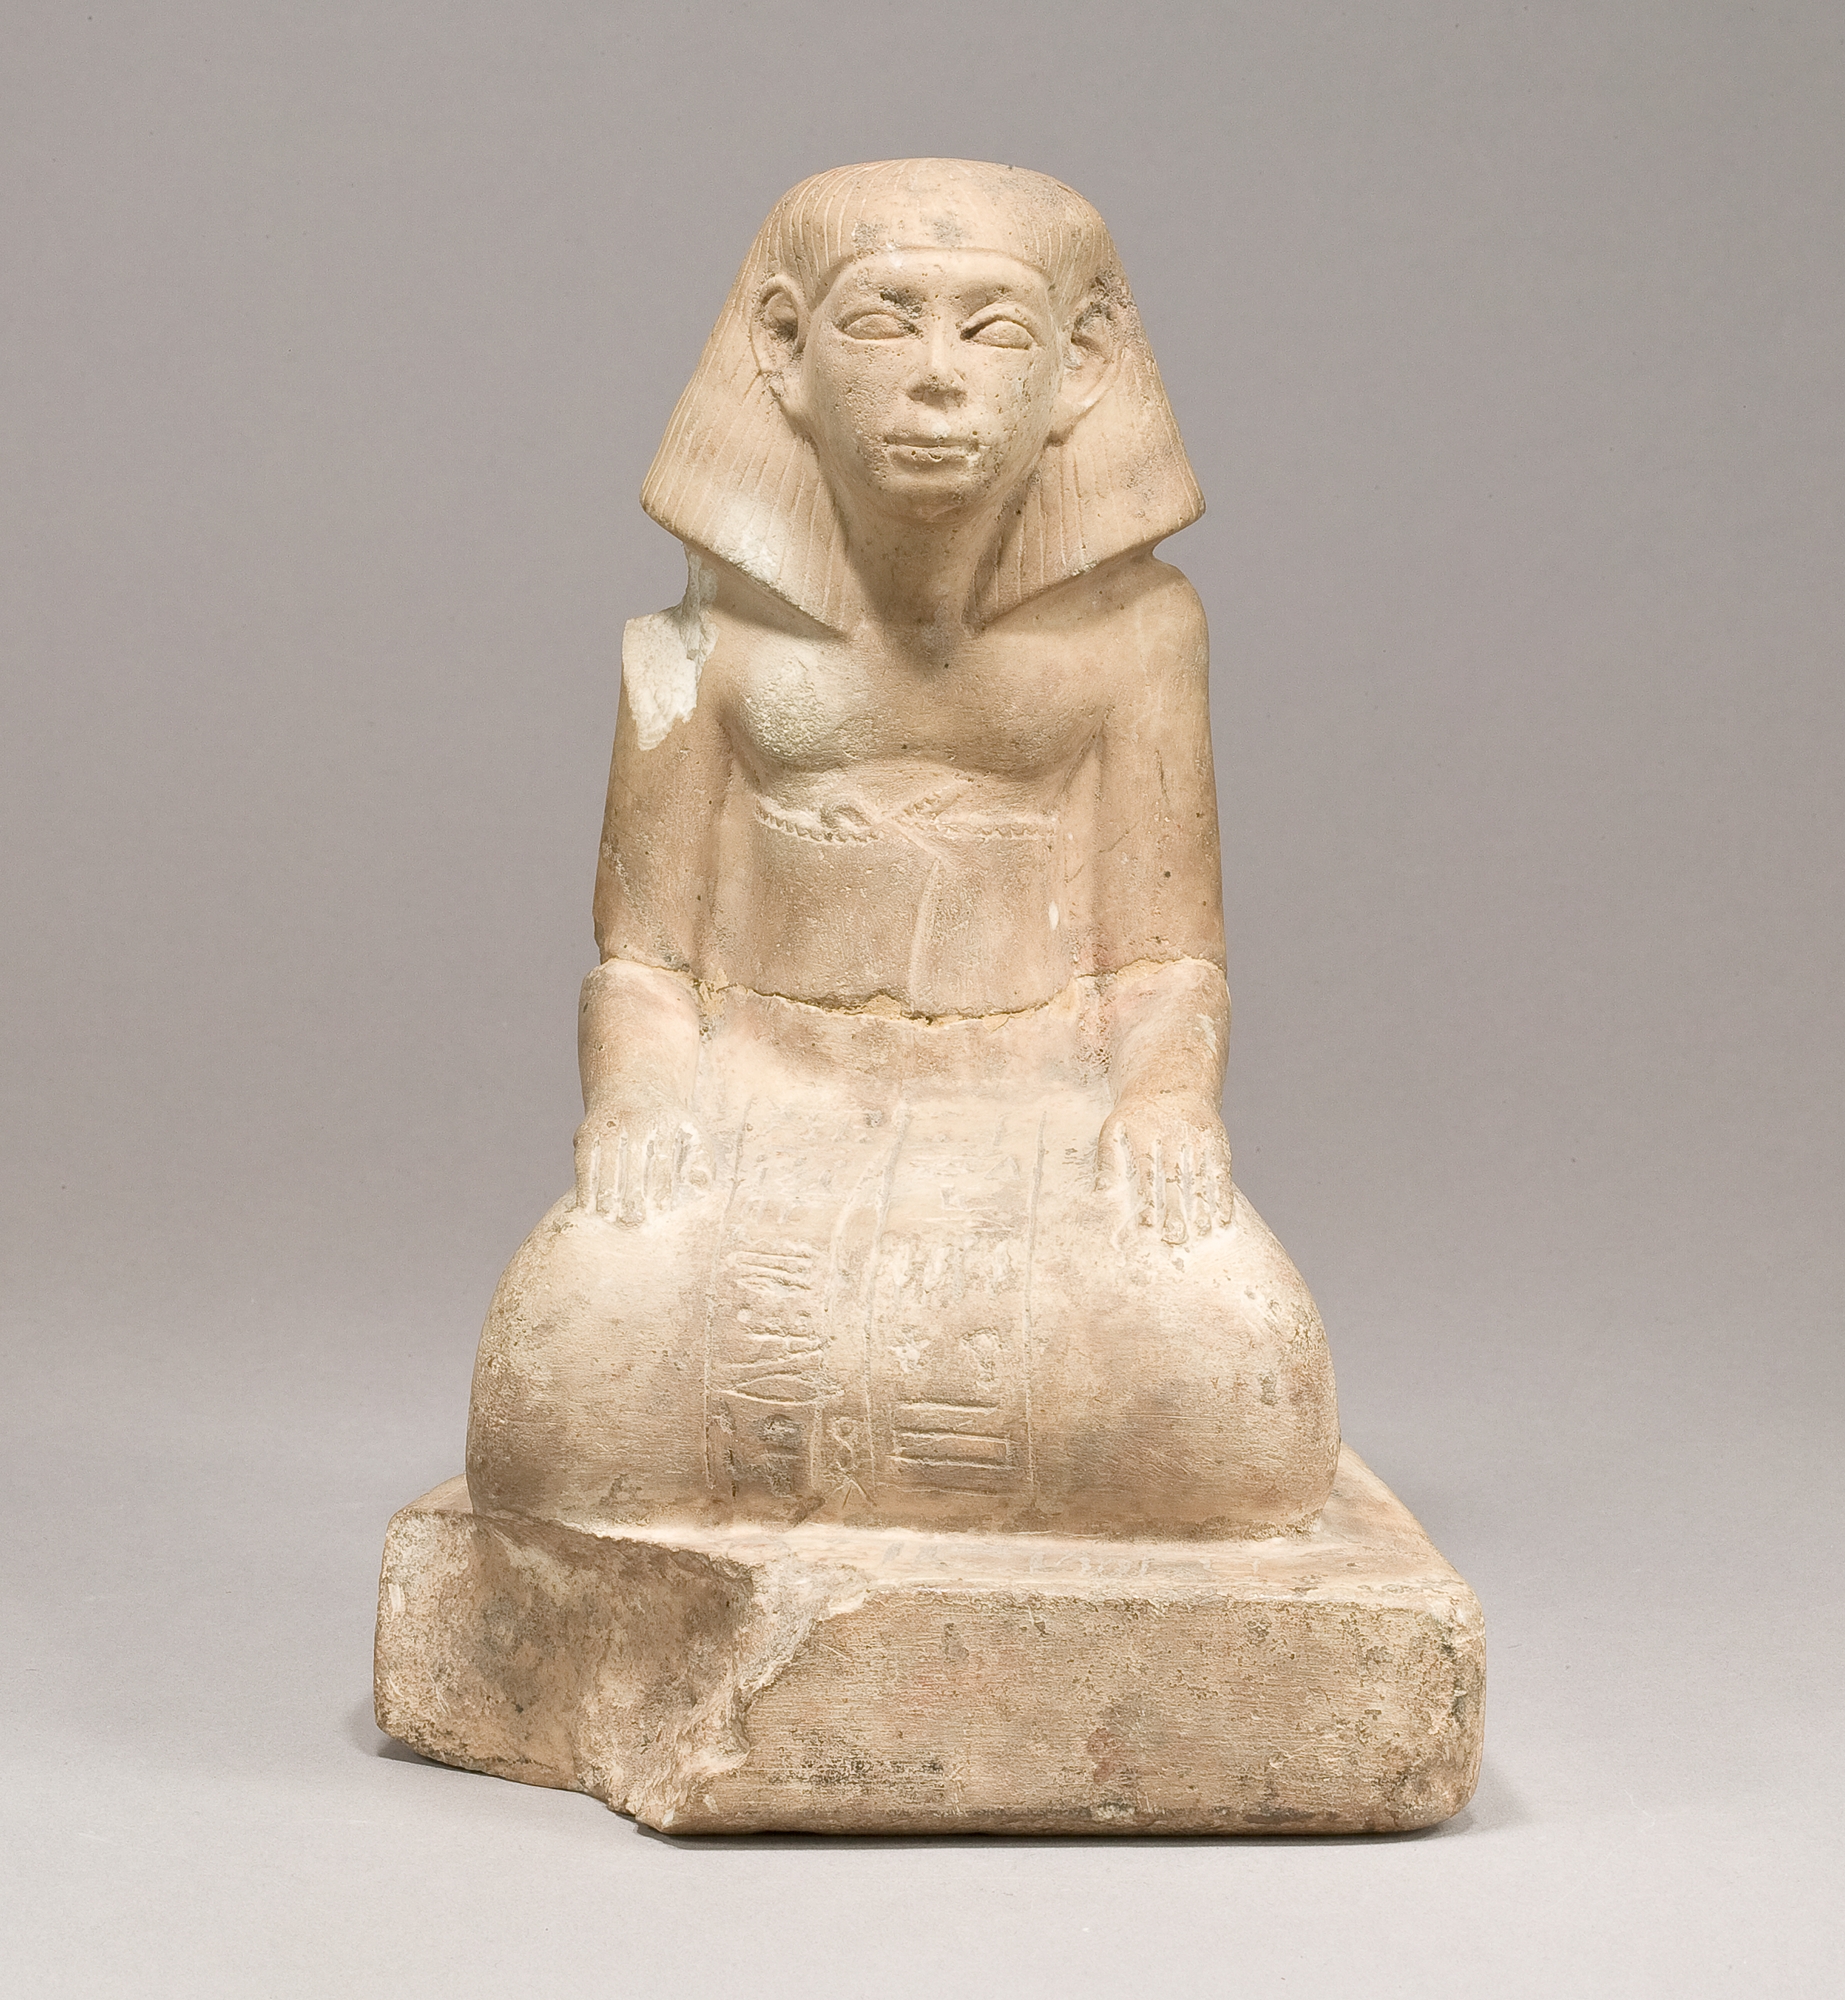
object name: statuette, ameny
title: Statuette of the Overseer of Priests Ameny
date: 1981-1802 BCE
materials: limestone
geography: fayum